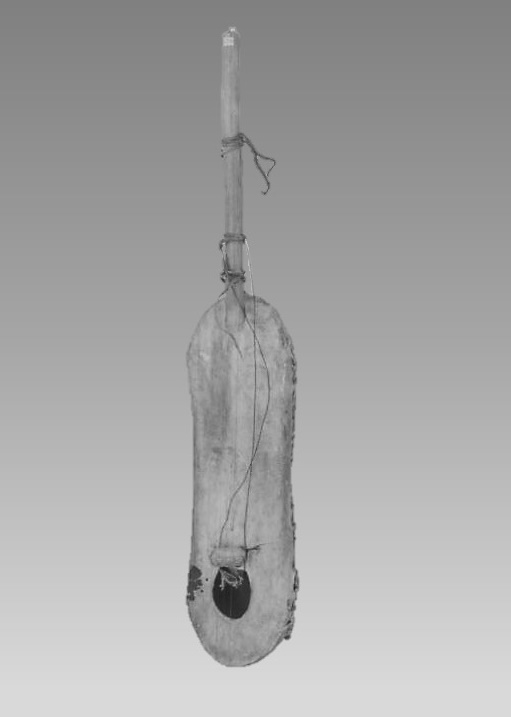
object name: gumuri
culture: saudi arabian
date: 1867-1900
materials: parchment, wood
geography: saudi arabia